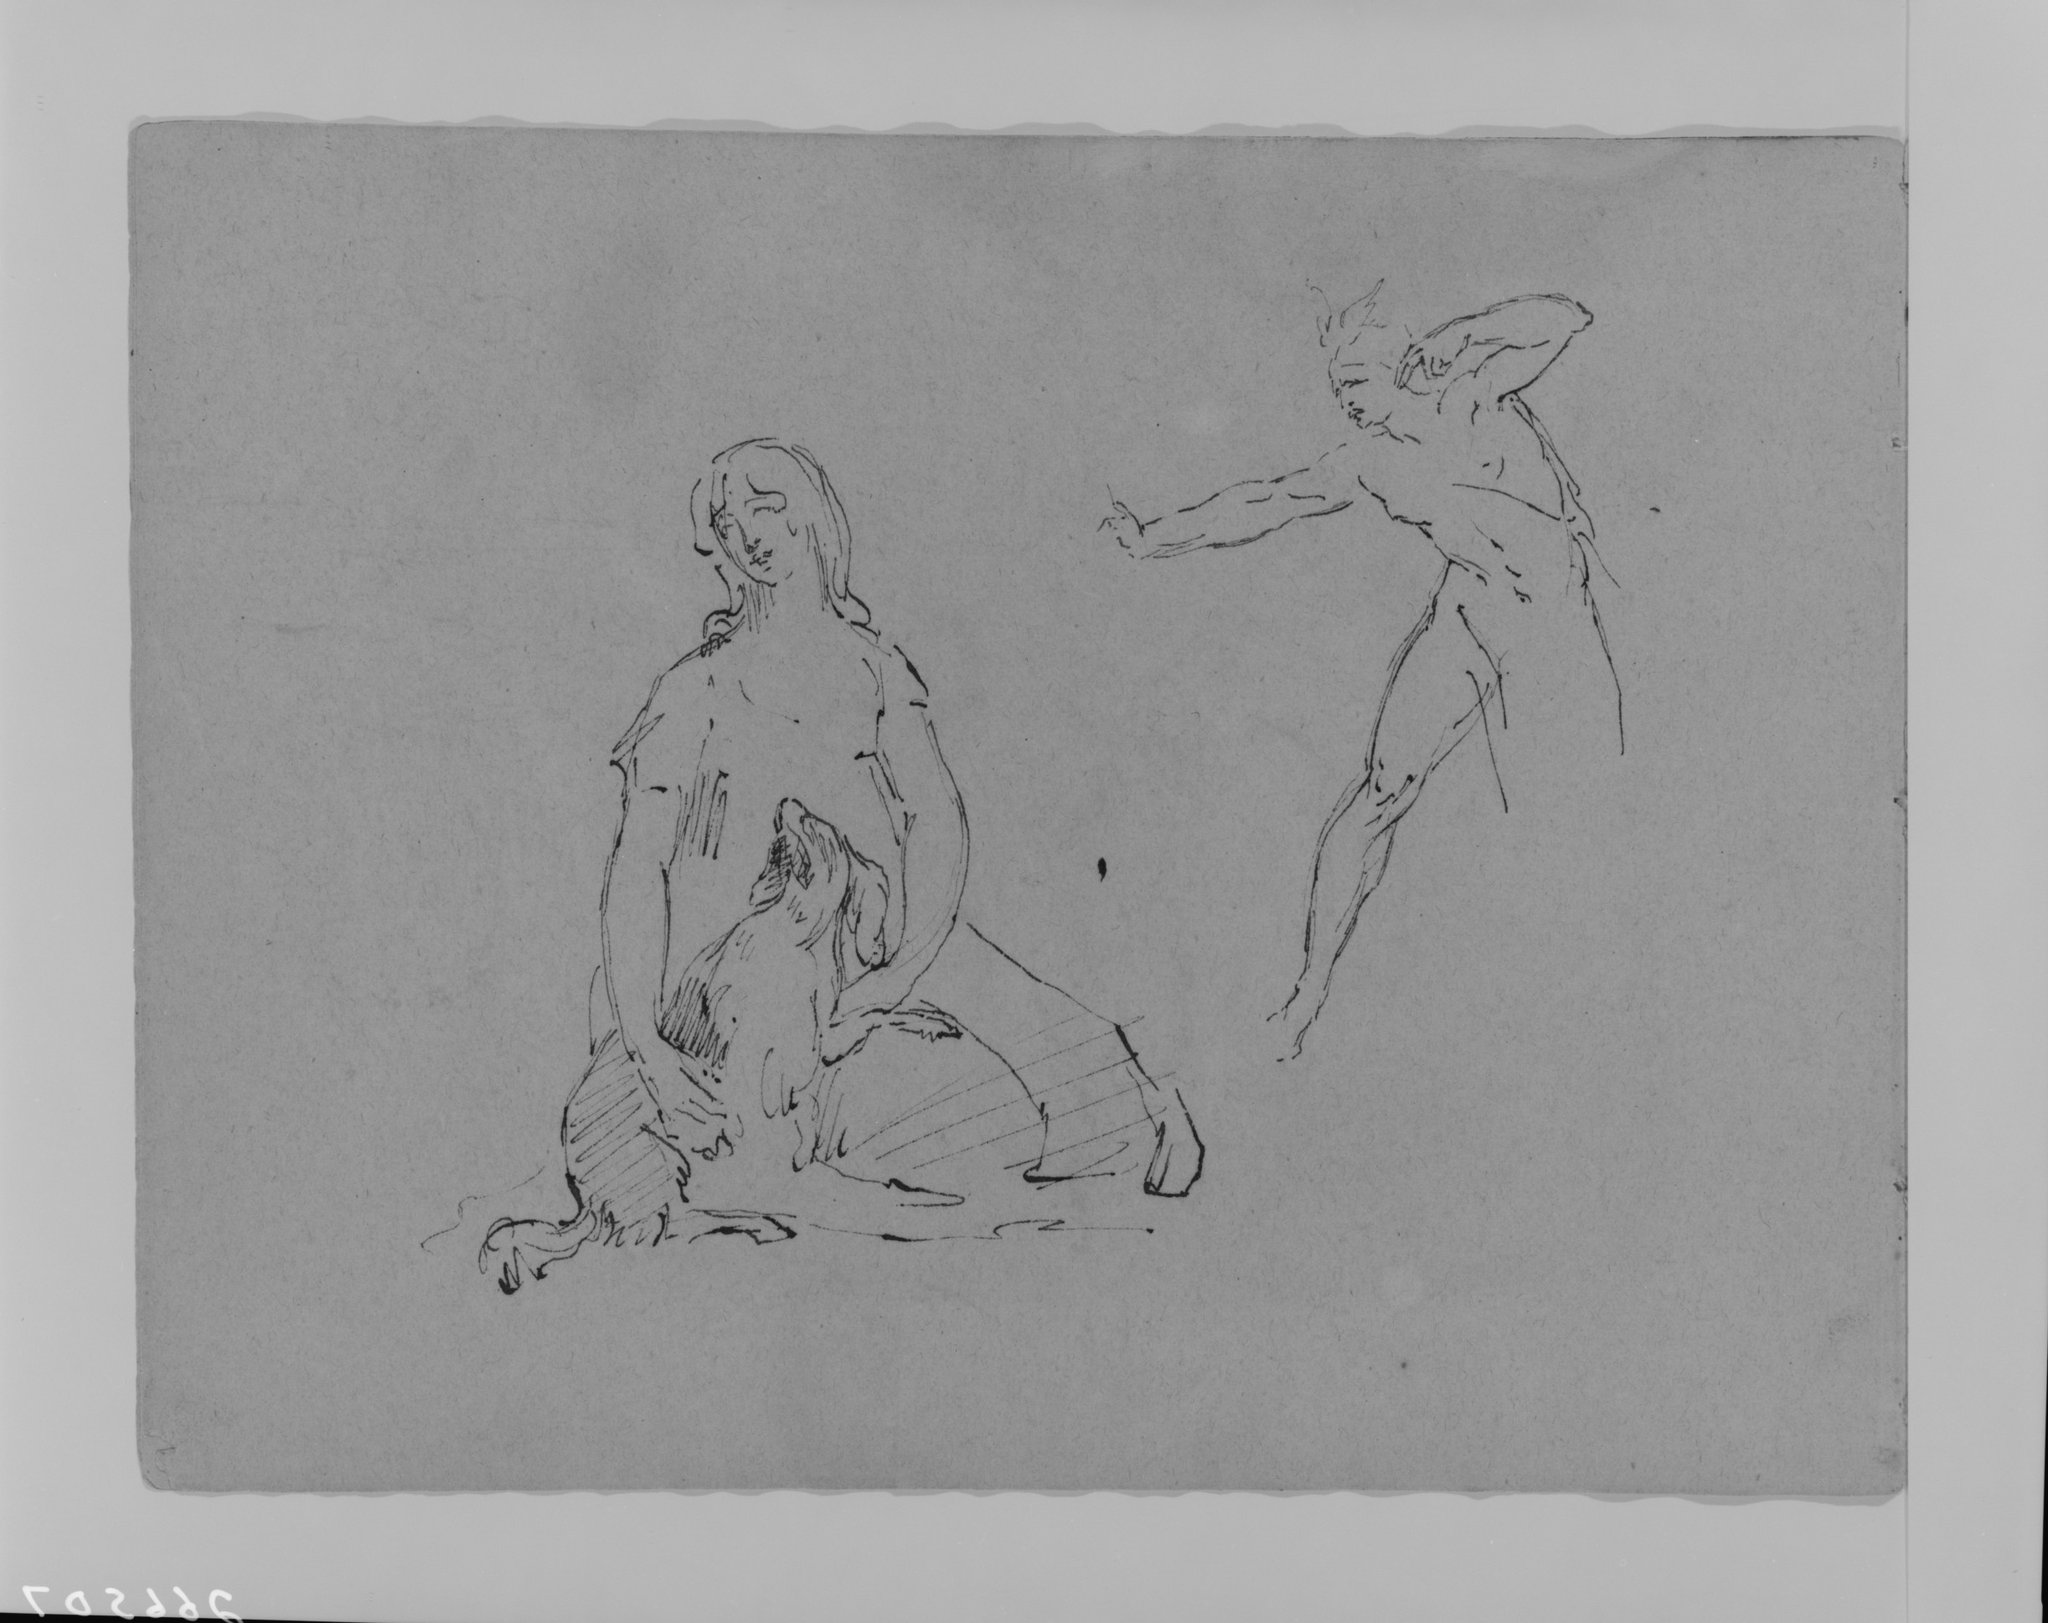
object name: drawing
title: (From Sketchbook)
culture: american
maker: thomas sully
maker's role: artist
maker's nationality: american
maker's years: 1783-1872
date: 1810-1820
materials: ink, paper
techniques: wash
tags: women,dogs